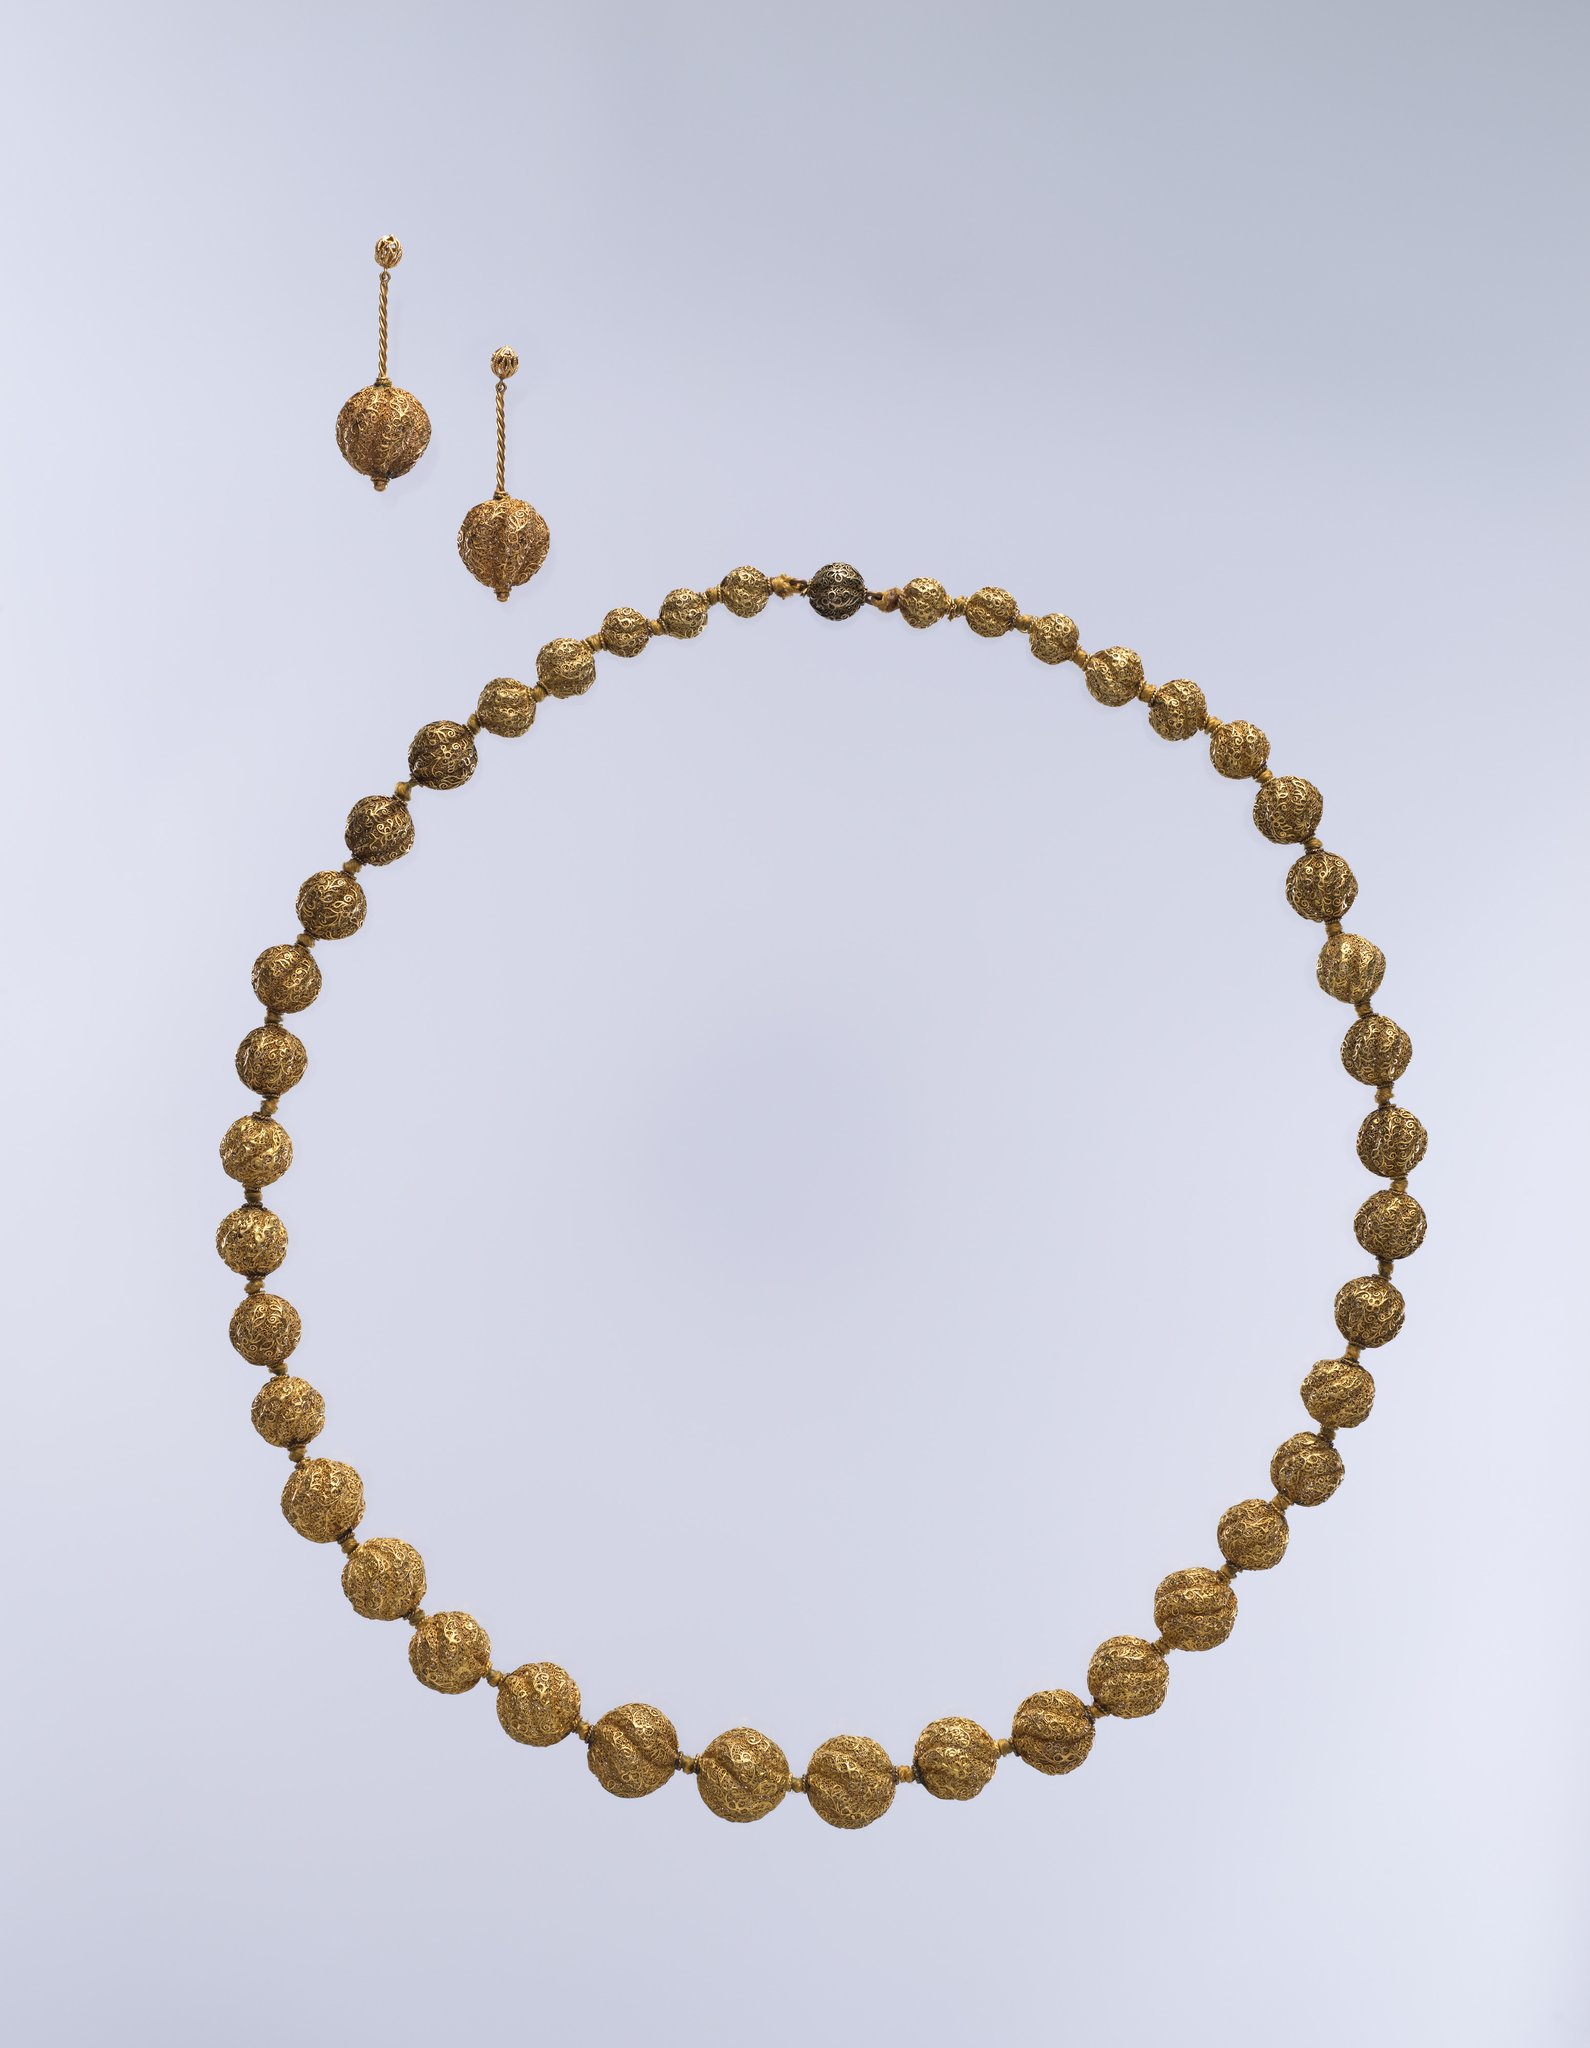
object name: necklace and earring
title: Necklace and Pair of Earrings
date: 1567-1600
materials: gold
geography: india